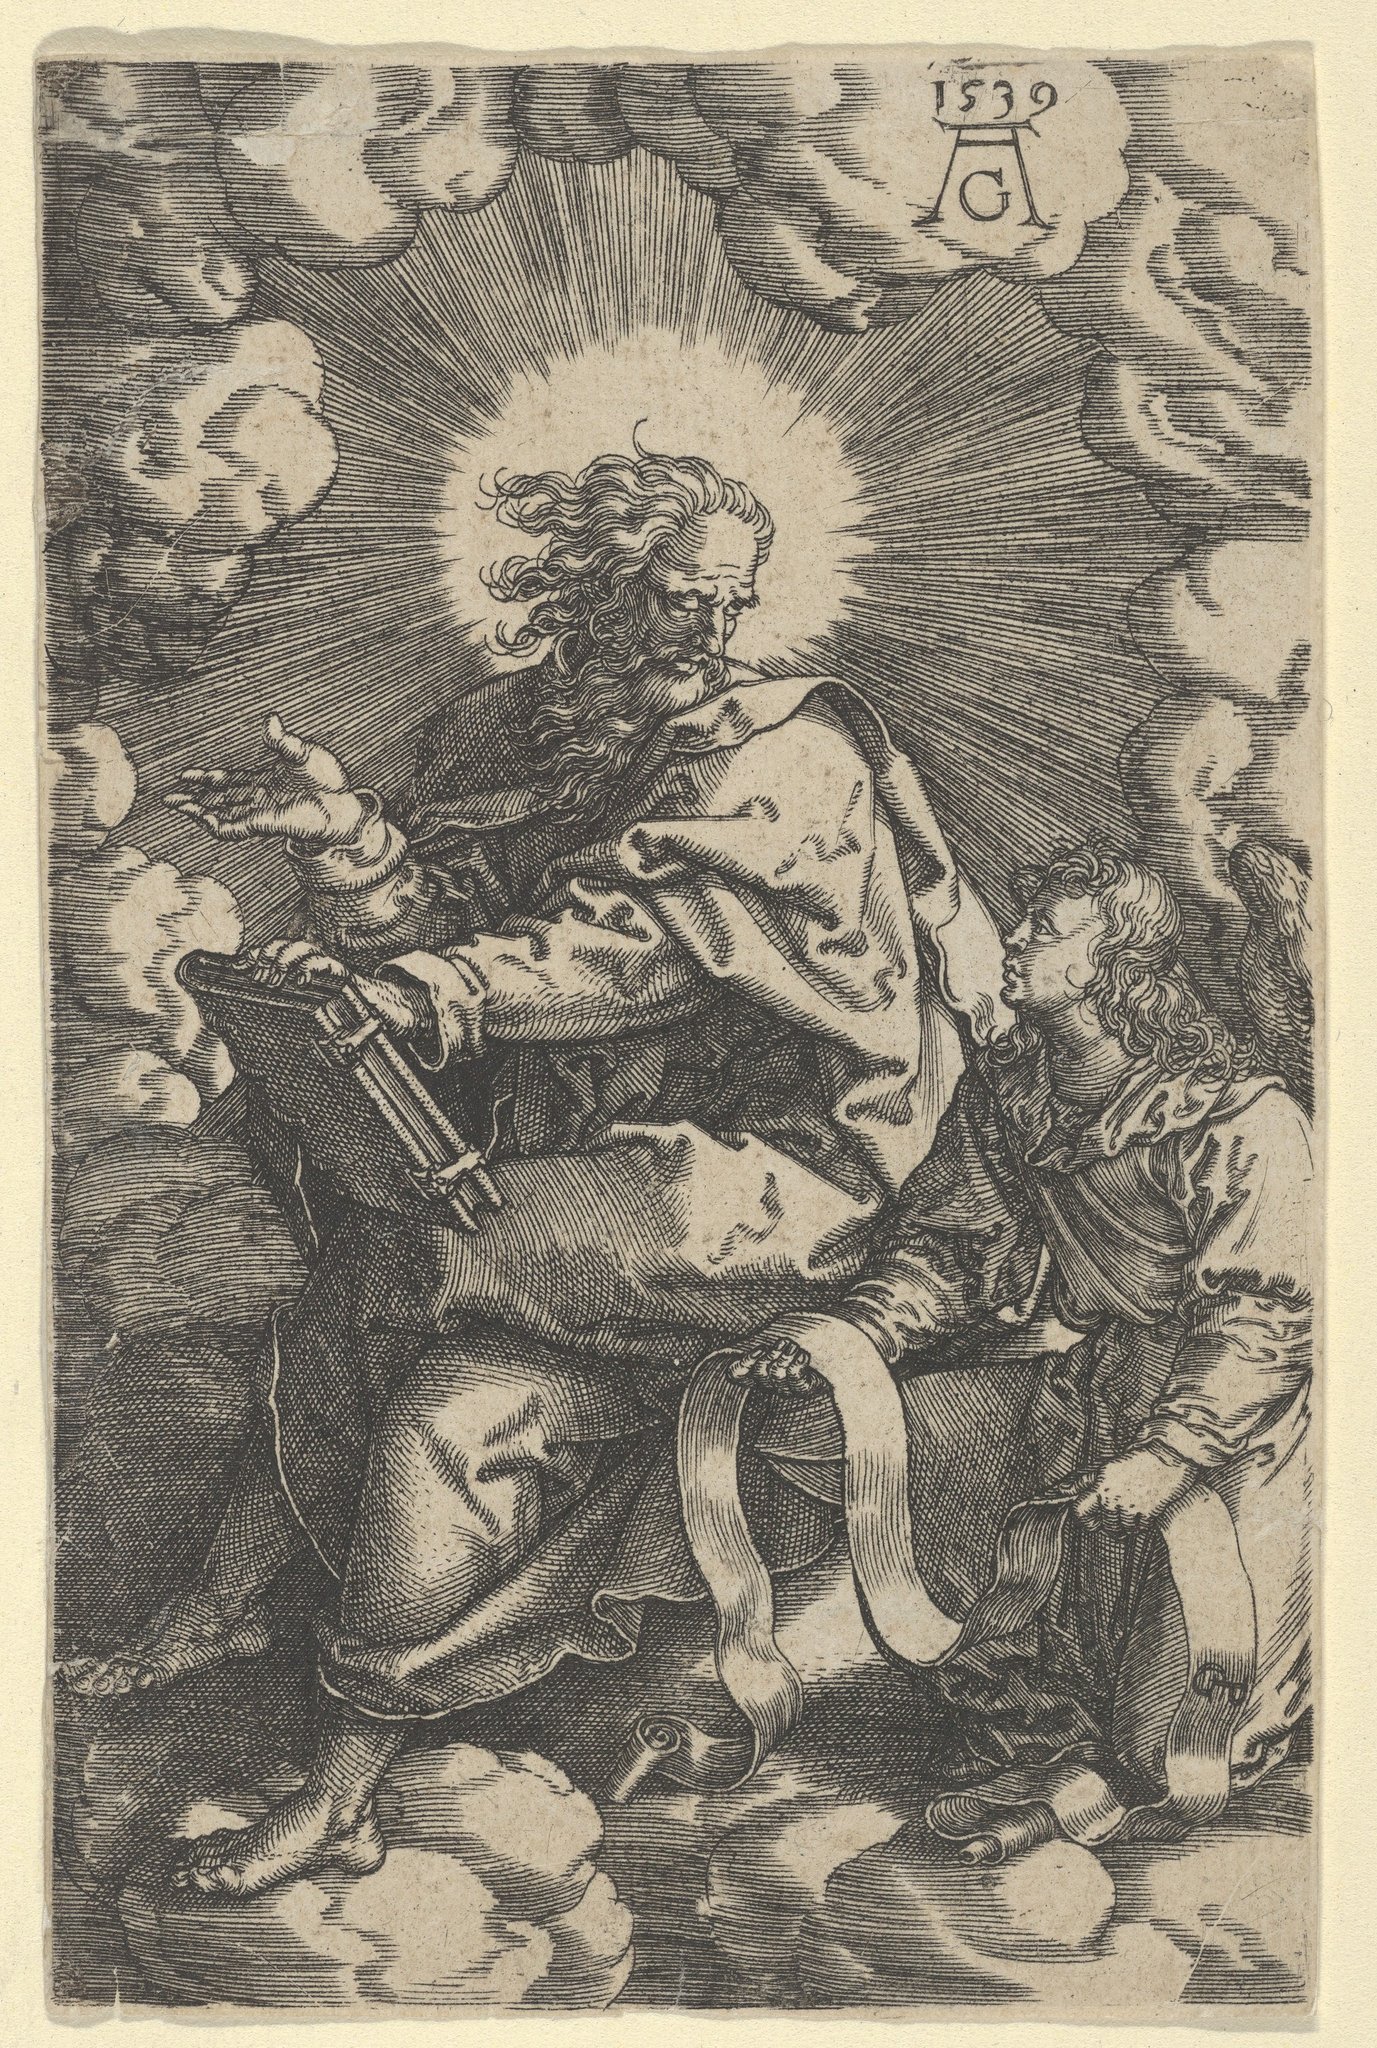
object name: print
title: Saint Matthew, from "The Four Evangelists"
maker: heinrich aldegrever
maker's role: artist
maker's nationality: german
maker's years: 1502-1561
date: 1539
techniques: engraving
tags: saint matthew